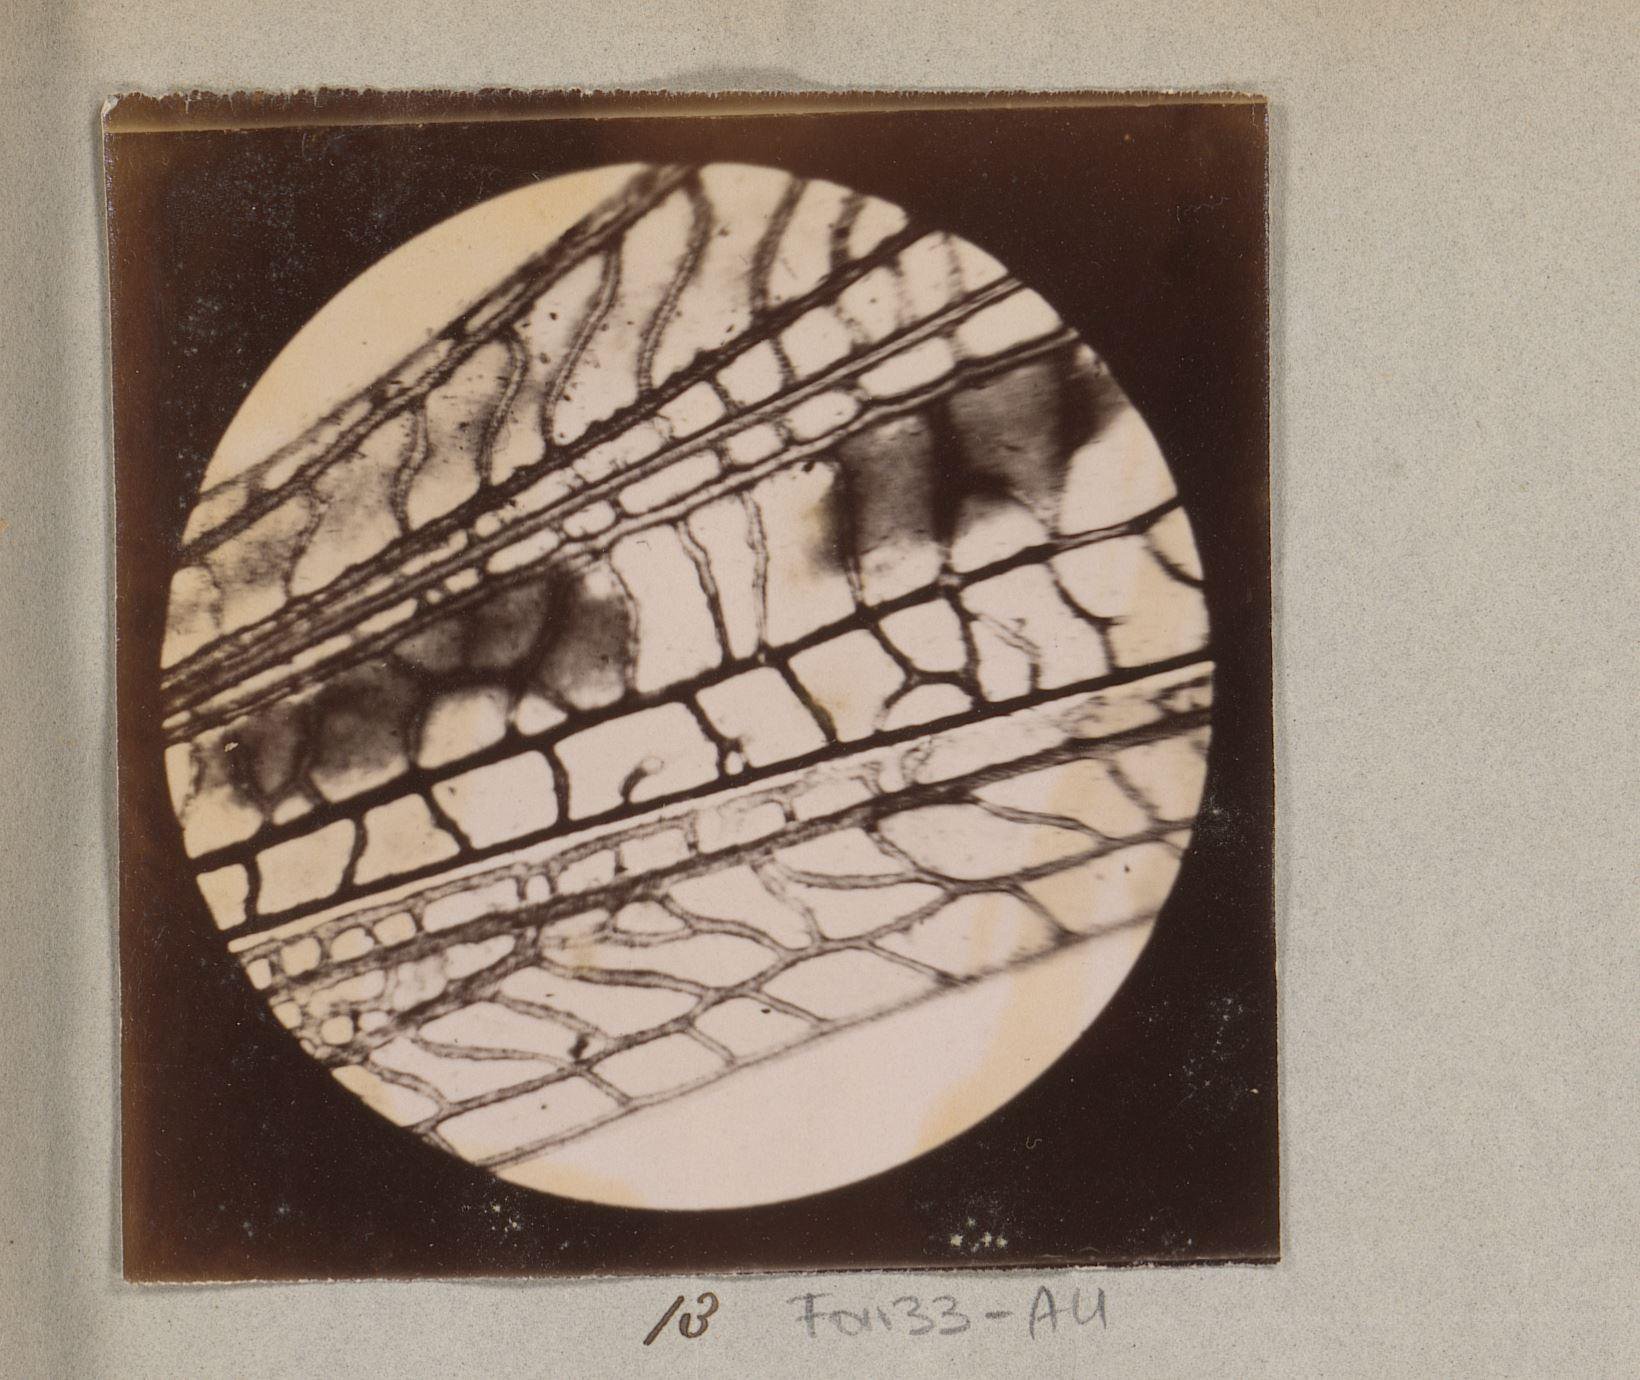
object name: album leaf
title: Microscopische opname van een sprinkhaanvleugel, negentig keer vergroot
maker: marinus pieter filbri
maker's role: instrument maker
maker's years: 1852-1917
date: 1887-1888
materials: paper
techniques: albumen print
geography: netherlands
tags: insects: grass-hopper, netherlands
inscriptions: number: ‘13’, inscription: ‘No. 13. Benaming Stuk van een vleugel v.e. sprinkhaan, 90 x vergroot, pose 4 min., bemerking uitgeschoven camera, Monc.’